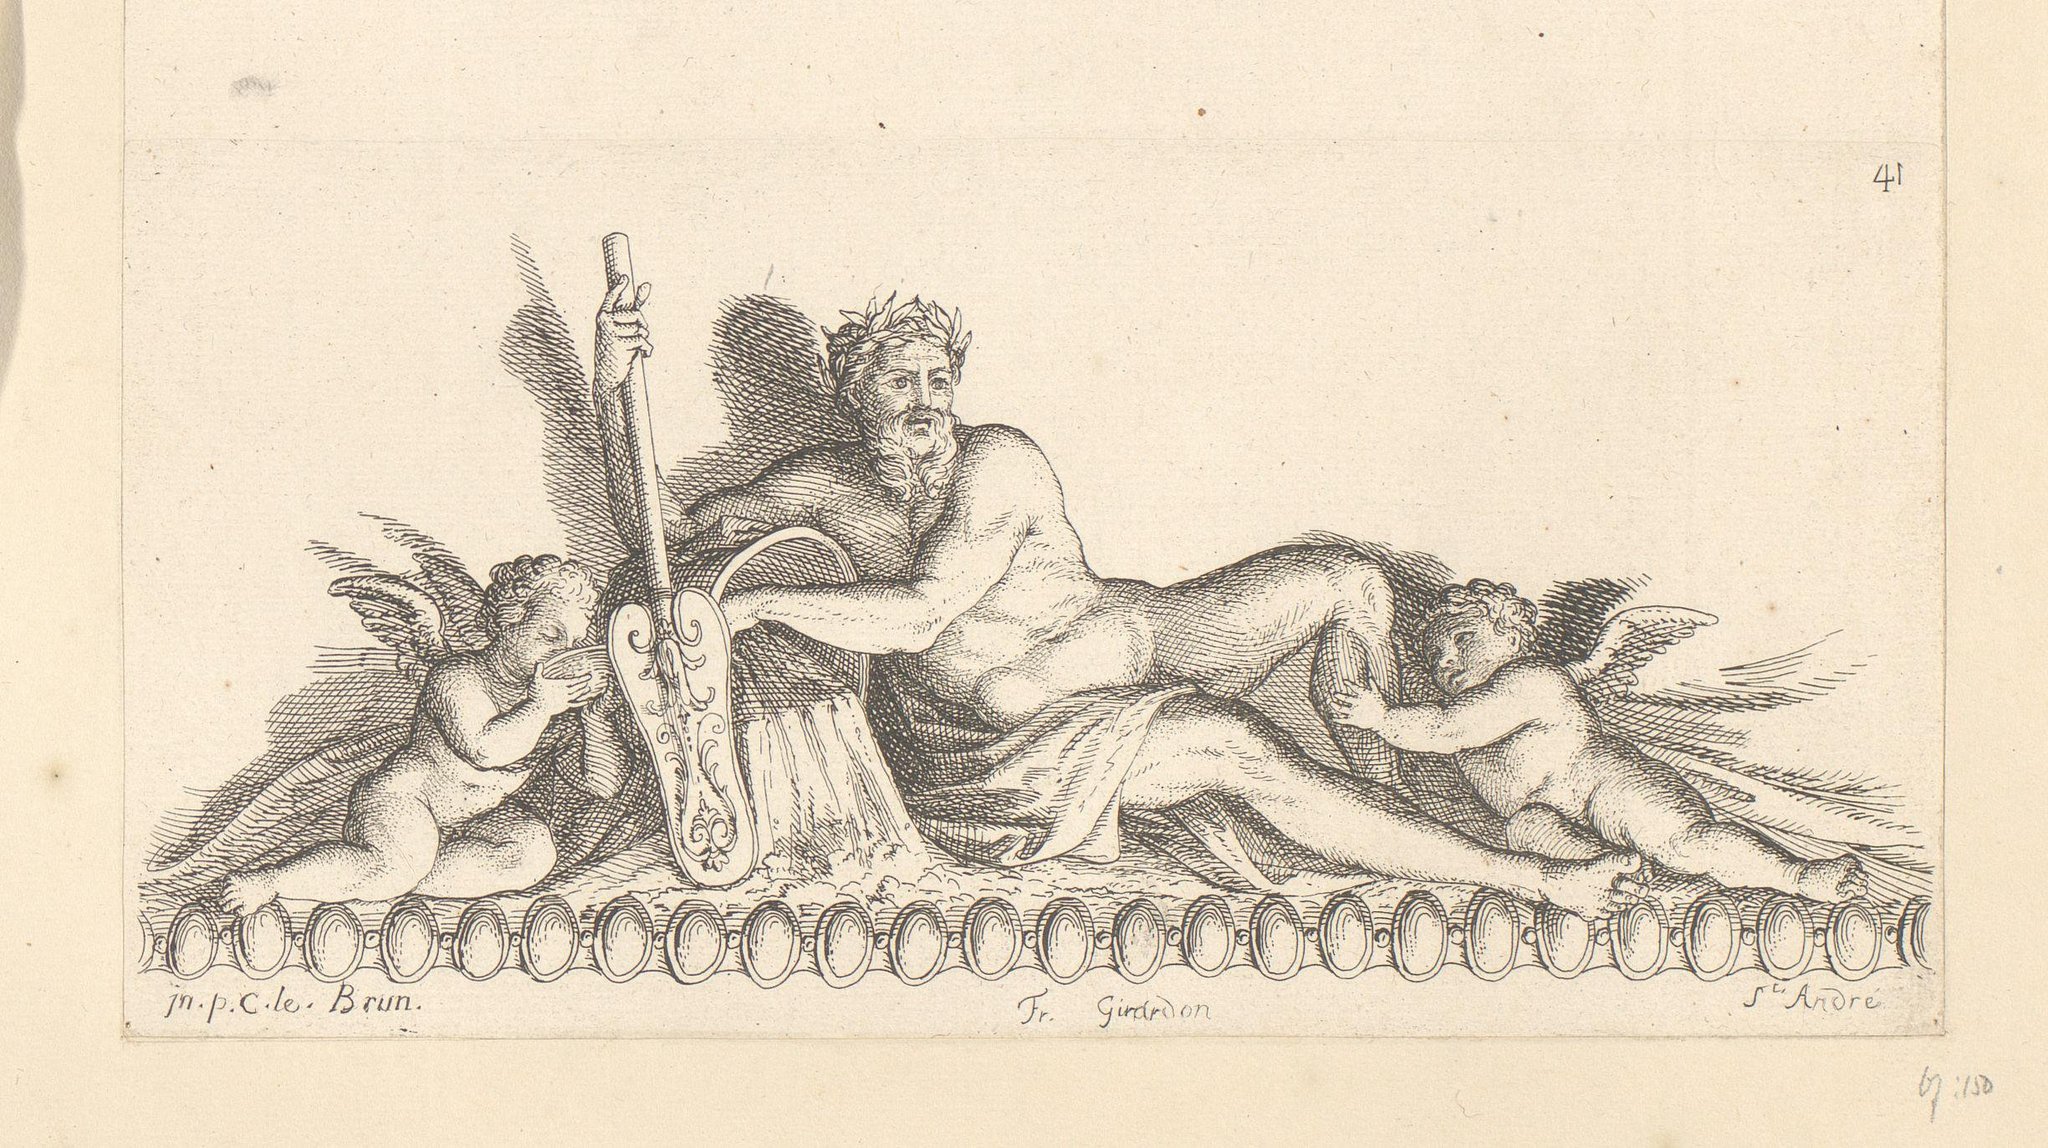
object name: album leaf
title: L'ouvrage de Charles le Brun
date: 1695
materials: paper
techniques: etching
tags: ornaments ~ art, river-gods, cupids: 'amores', 'amoretti', 'putti'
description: Deze prent maakt deel uit van een album.